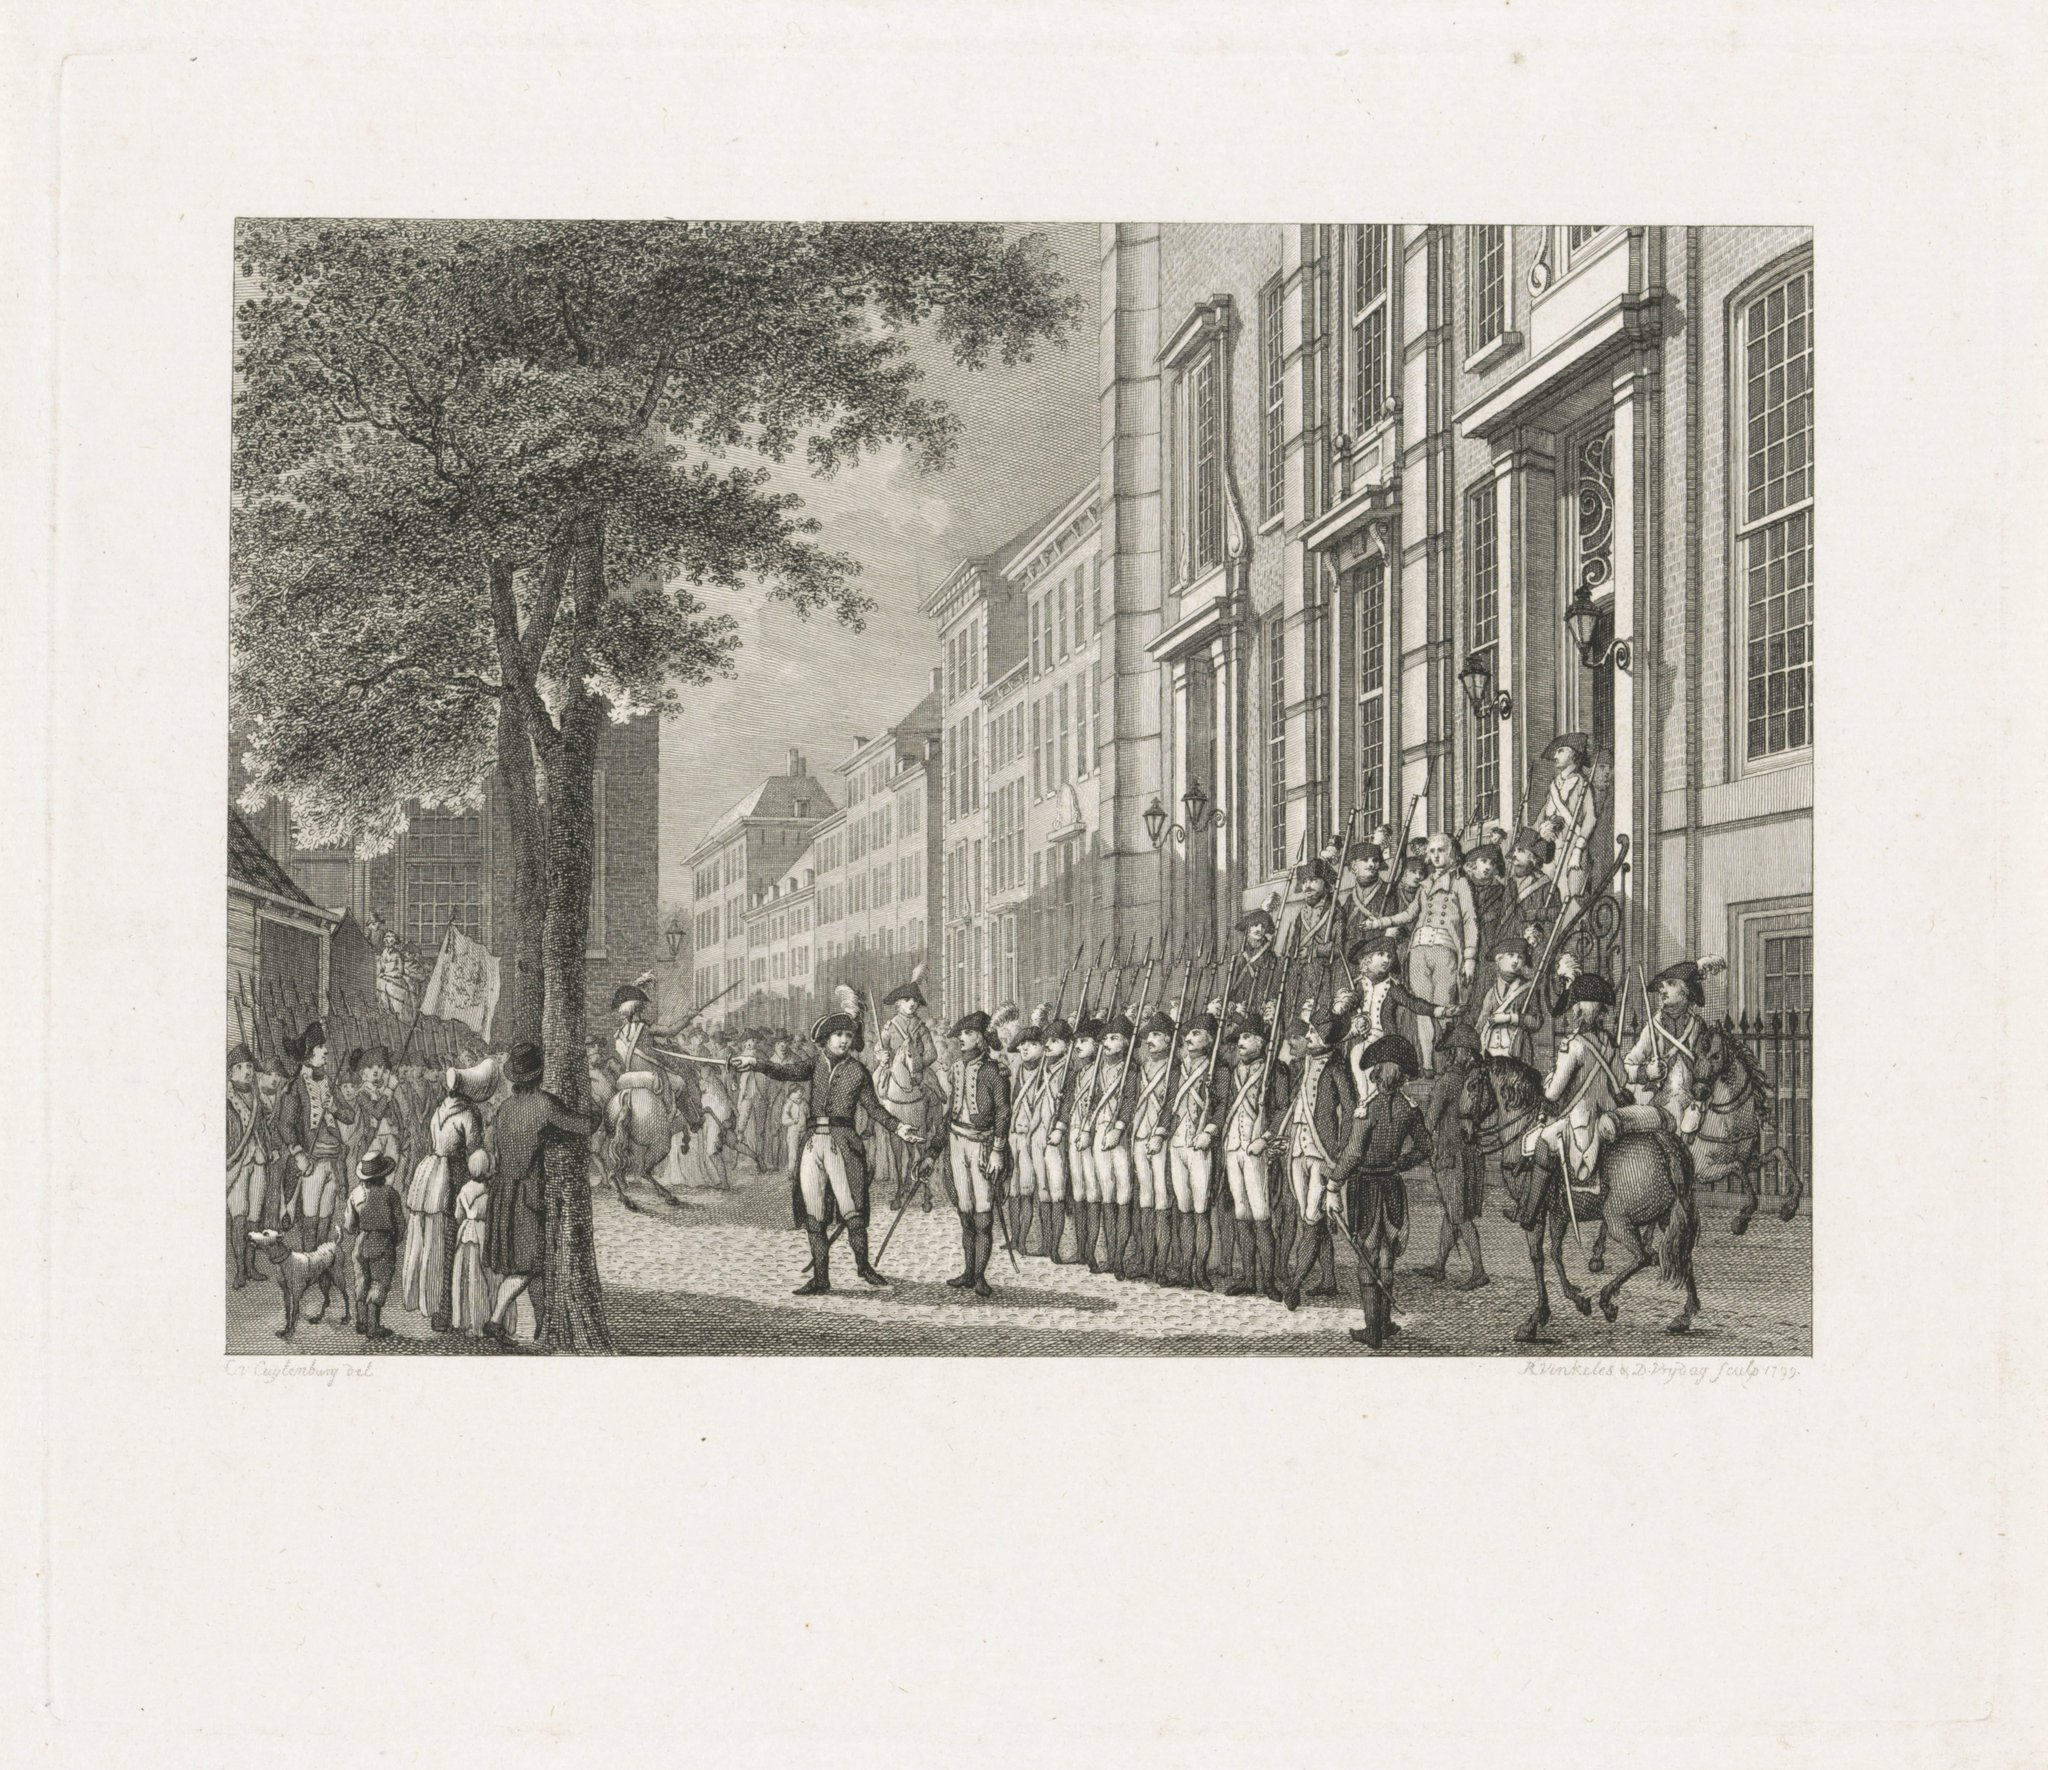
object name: print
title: Arrestatie van S.J van Langen, 1798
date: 1799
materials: paper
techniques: engraving, etching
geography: netherlands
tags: leiden, arrest (of criminal)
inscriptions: collector's mark: Lugt 2228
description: Arrestatie van Stephanus Jacobus van Langen, lid van het Uitvoerend Bewind, door een detachement militairen vóór het Logement aan het Plein te Den Haag,12 juni 1798. Op beschuldiging van zelfverrijking.